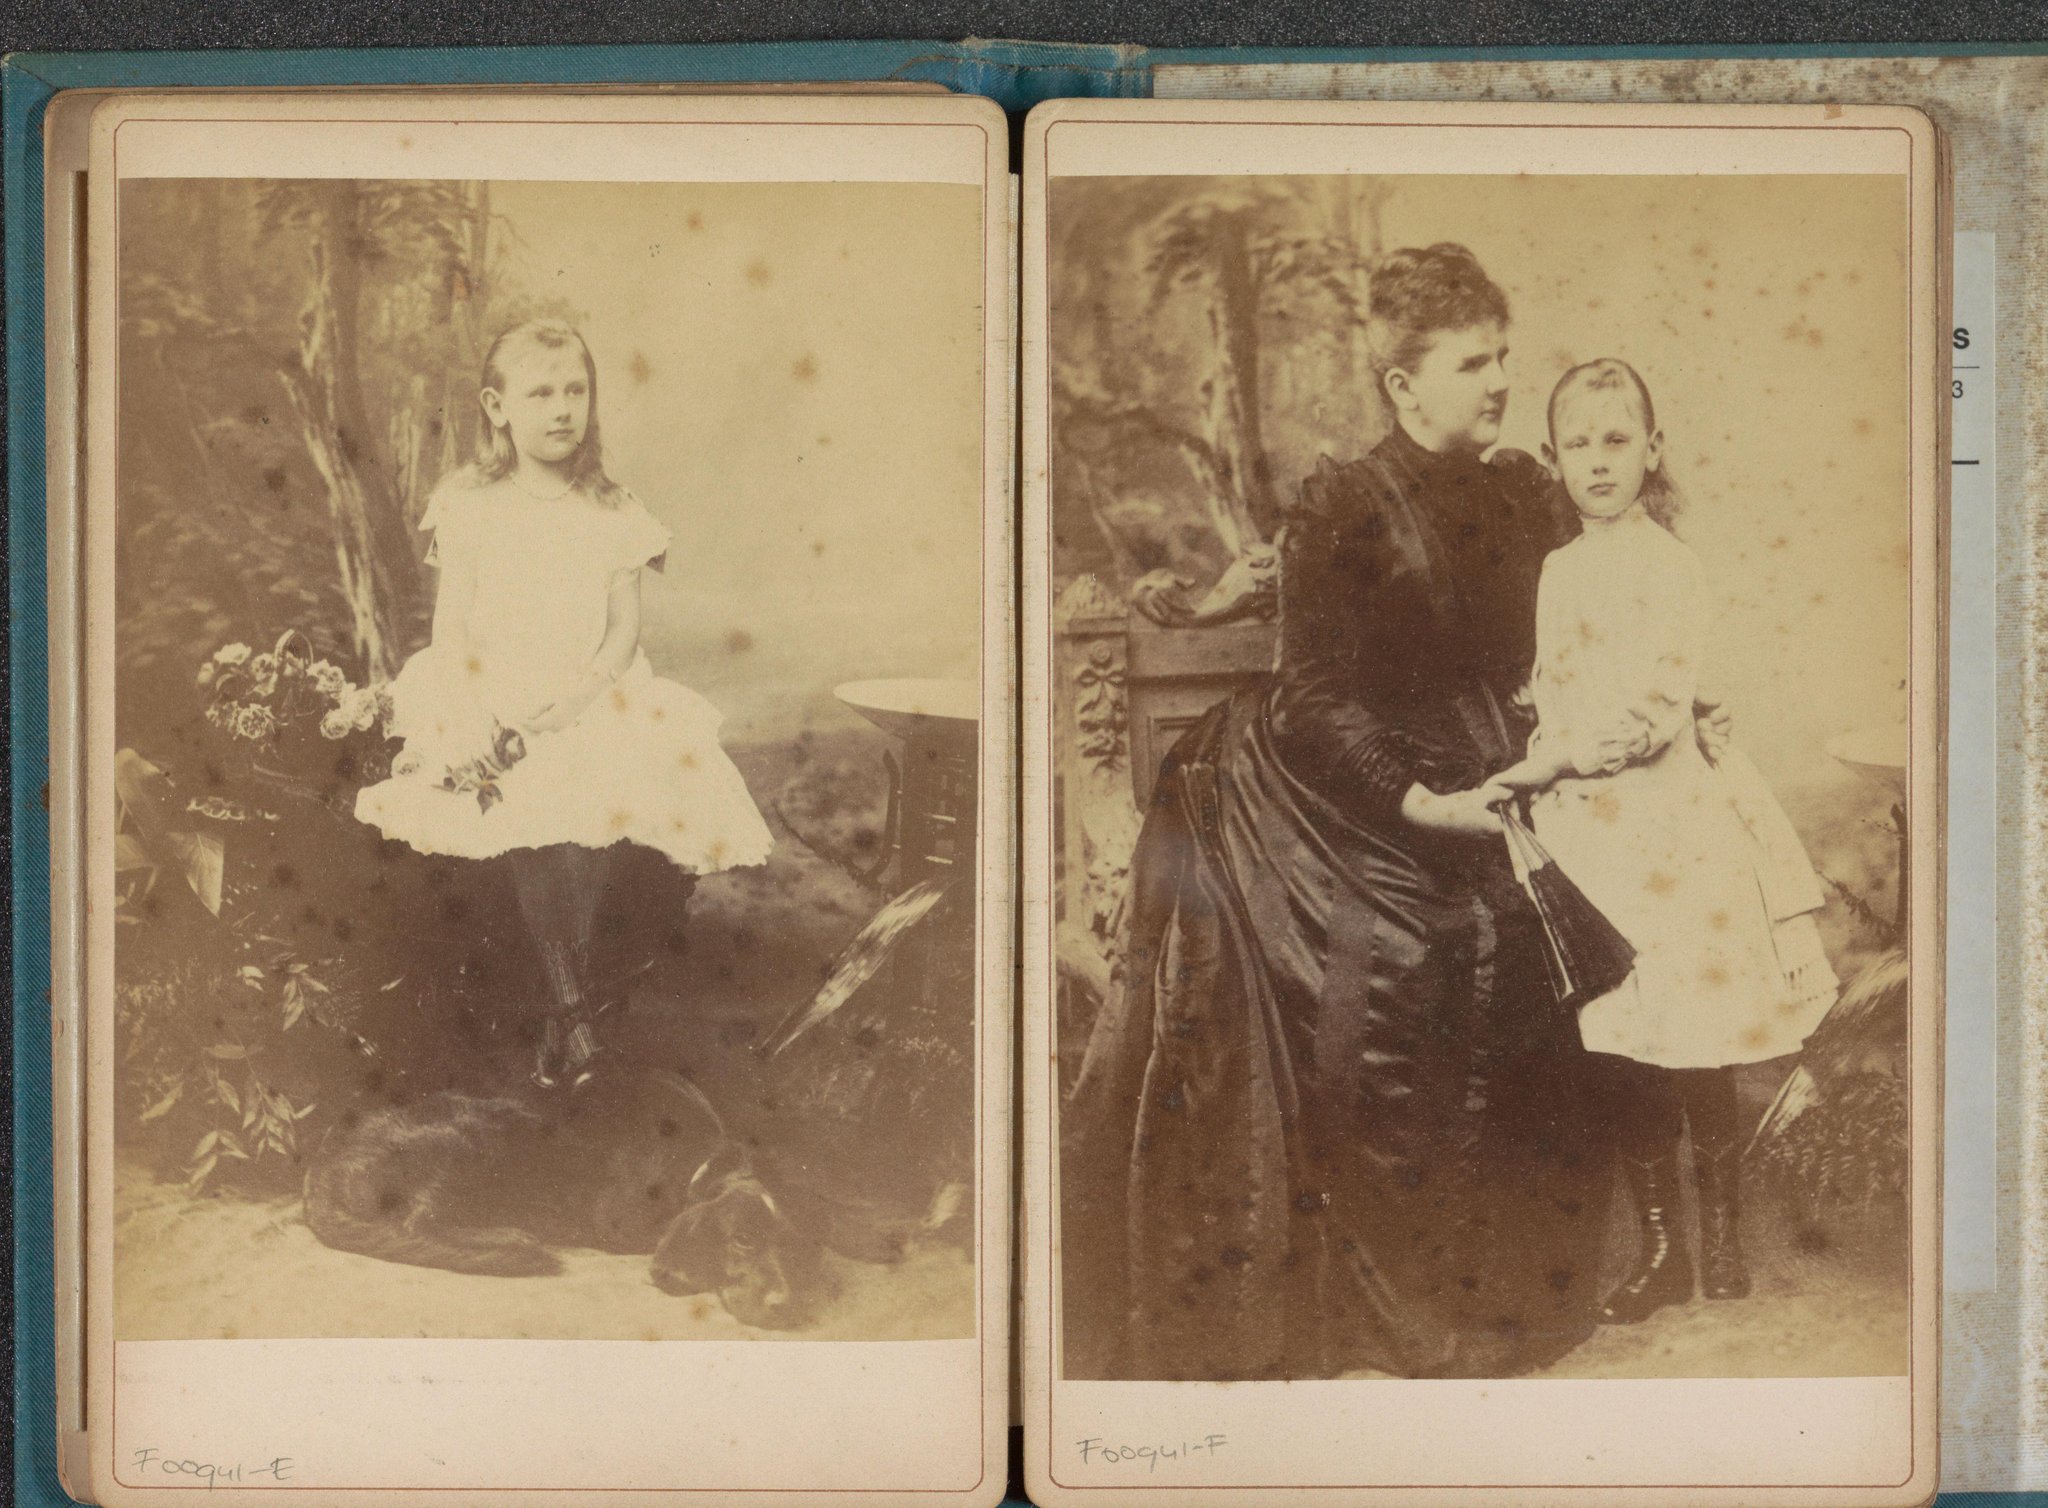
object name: photograph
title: Portret van prinses Wilhelmina als meisje met haar hond Swell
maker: Anonymous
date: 1889-1890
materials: cardboard, photographic support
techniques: albumen print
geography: netherlands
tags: the hague, wilhelmina of the netherlands, child, dog, netherlands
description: Onderdeel van Fotoalbum met opnames van prinses Wilhelmina als kind tot aan haar inhuldiging in 1898.